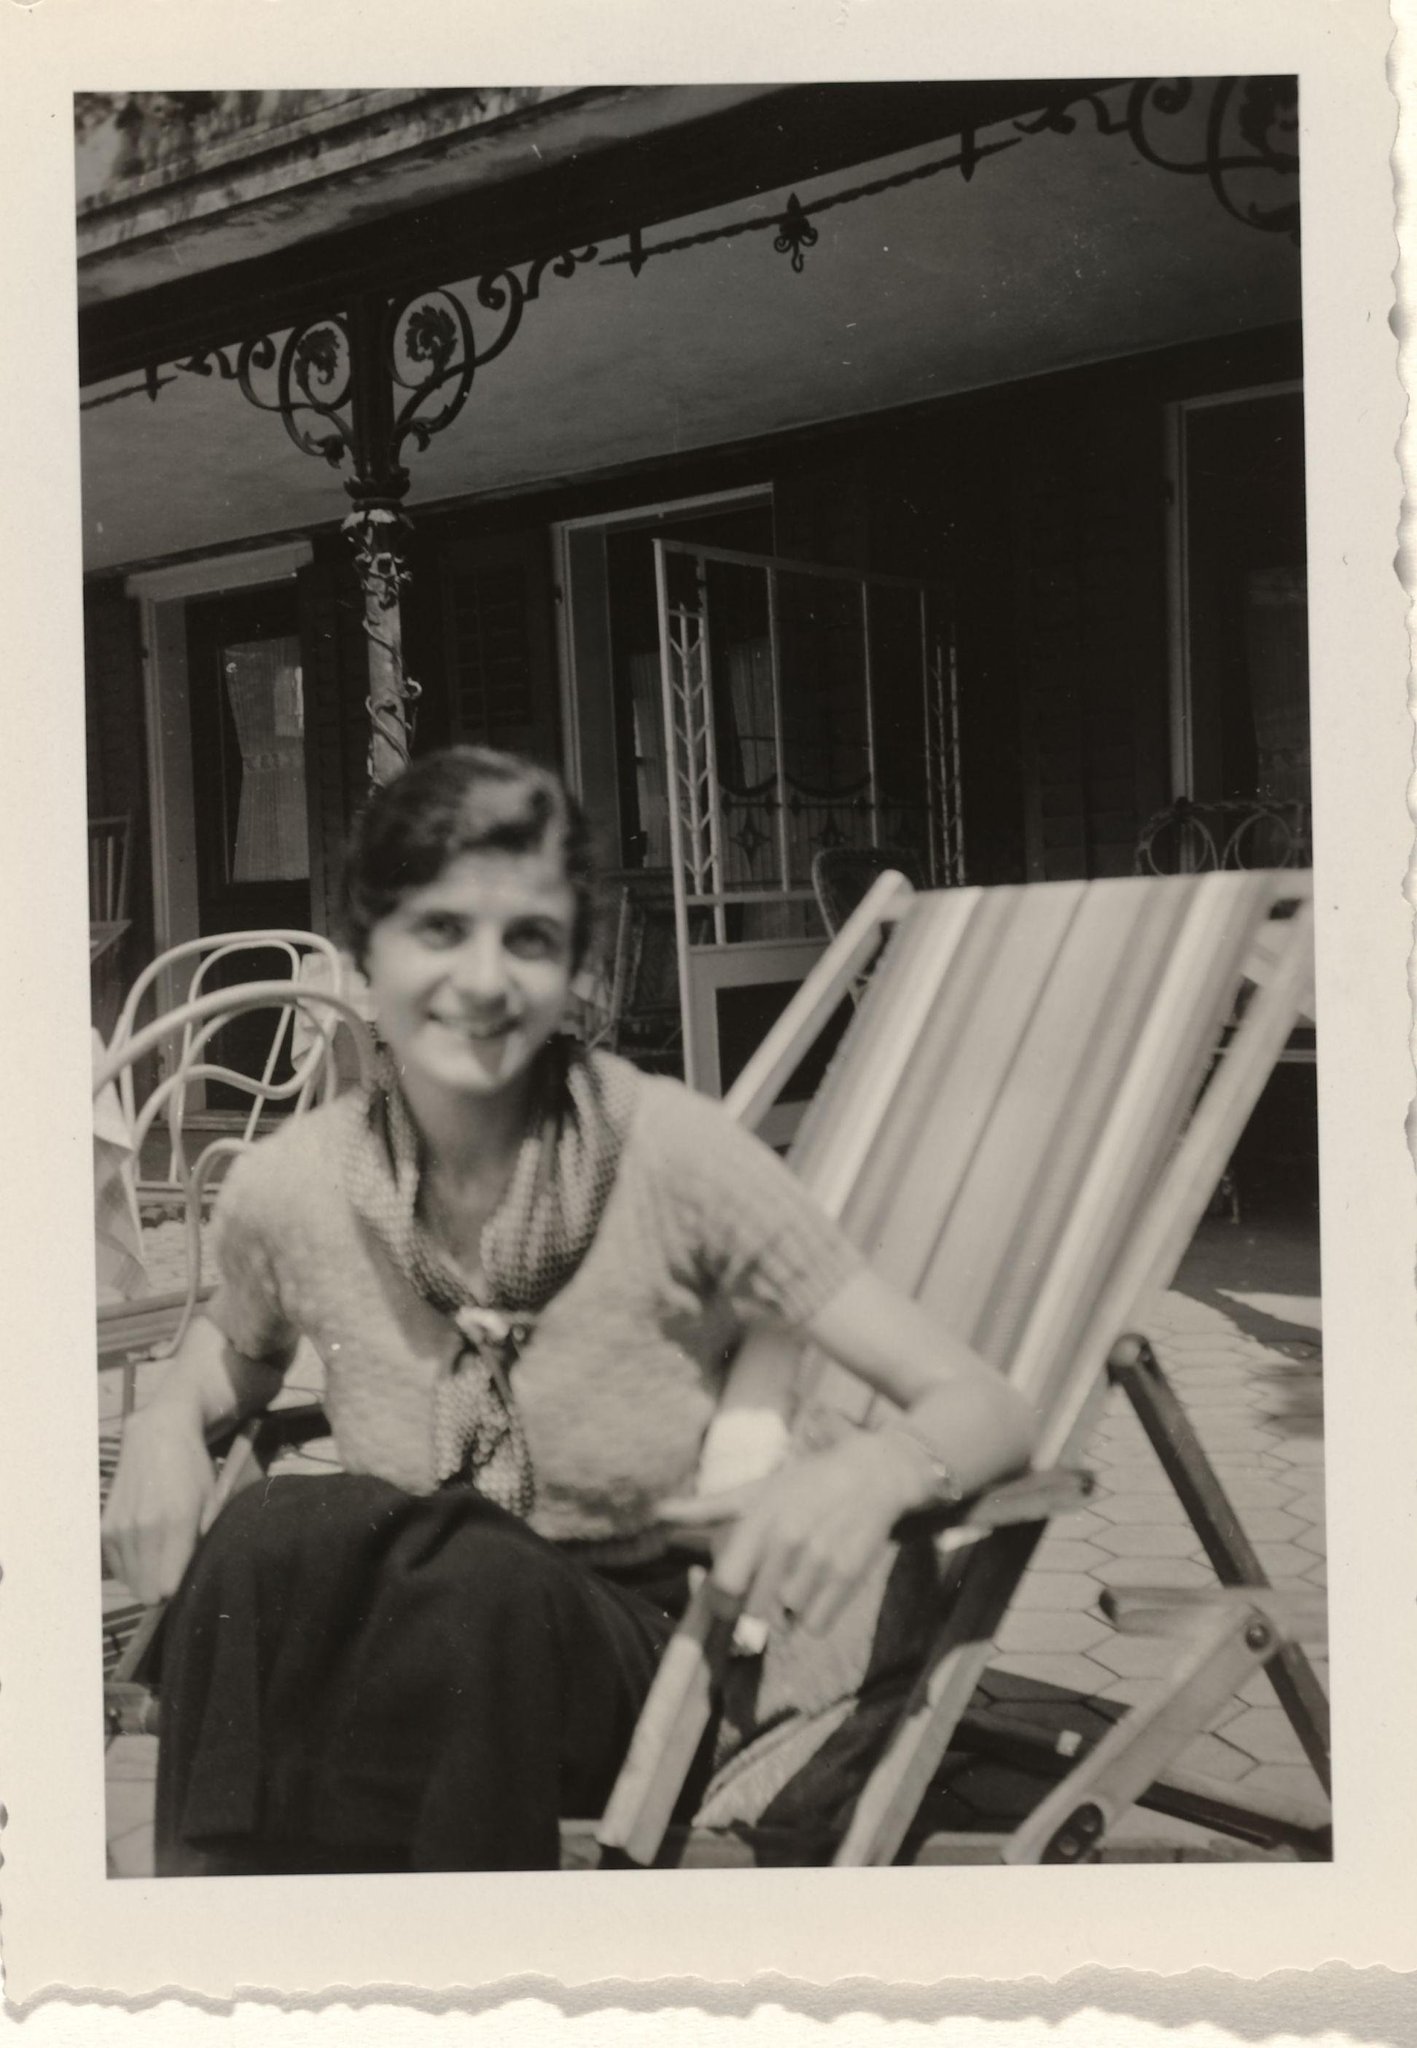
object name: photograph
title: Lid van de huishoudelijke staf van de familie Wachenheimer, gezeten in een ligstoel op een terras tijdens een vakantie van de familie Wachenheimer in Zwitserland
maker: Anonymous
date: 1908-1935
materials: photographic support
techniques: gelatin silver print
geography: switzerland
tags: switzerland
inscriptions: inscription: ‘Aug.35. Auf der Terrassen (von Isabel auf- genommen.)’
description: Onbekend lid van de huishoudelijke staf van de familie Wachenheimer, gezeten in een ligstoel op een terras.